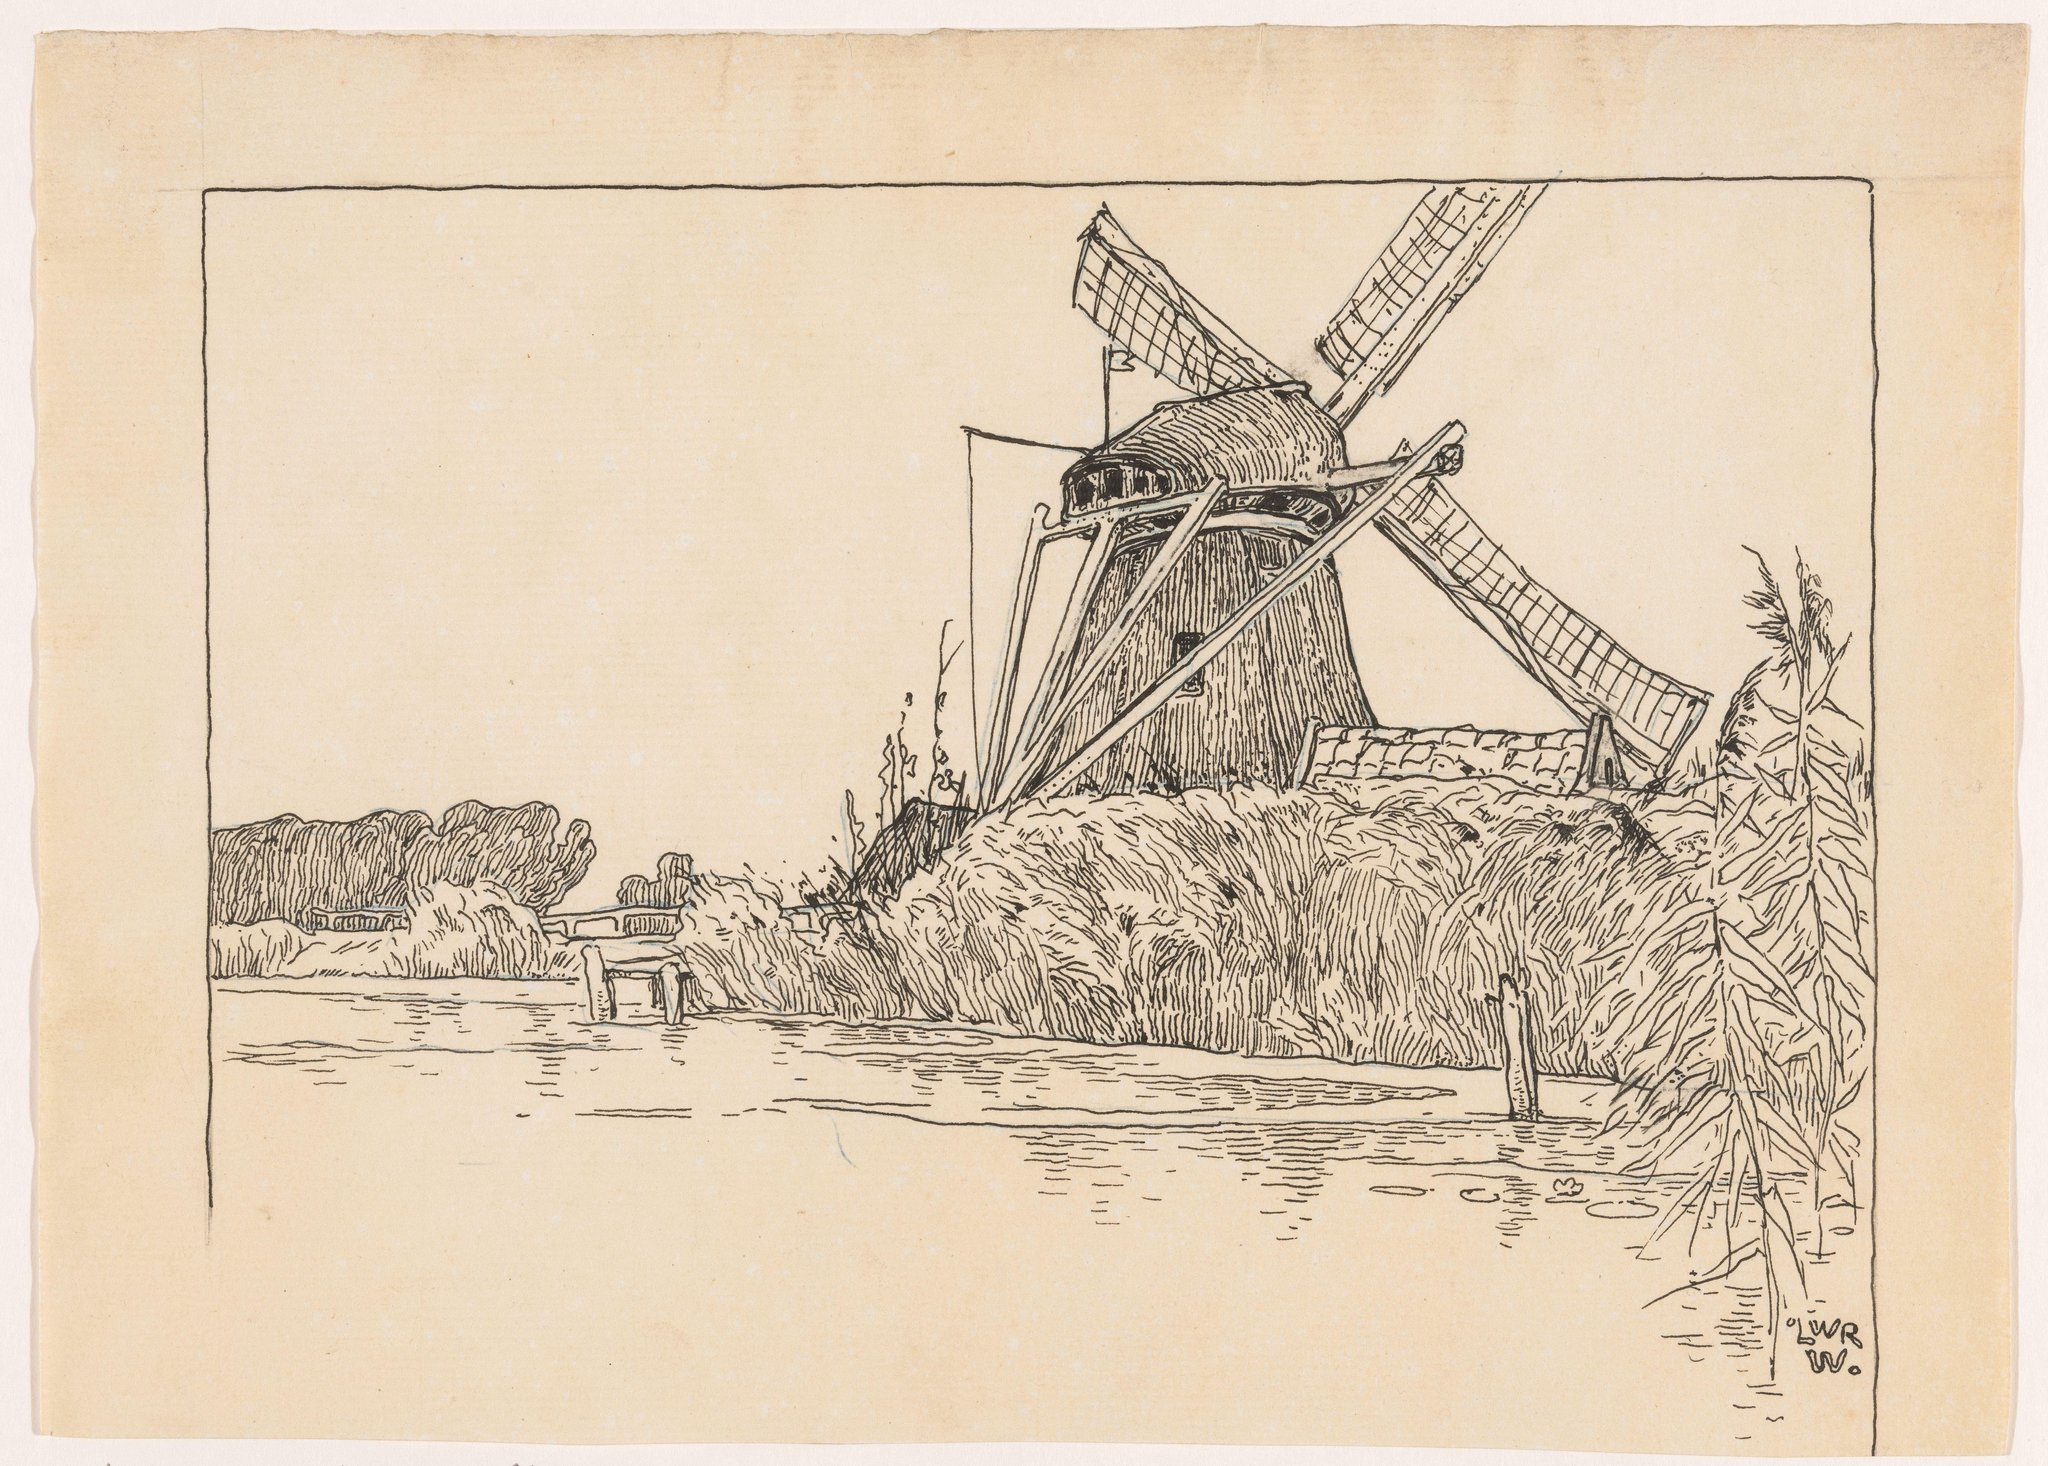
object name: drawing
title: Molen aan een waterkant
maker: willem wenckebach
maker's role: designer, draughtsman, painter, print maker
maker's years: 1860-1937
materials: ink, paper, pencil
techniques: pen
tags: watermill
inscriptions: collector's mark: Lugt 2228a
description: Ontwerp voor: Knappert, Emilie C. Kijkjes in de plantenwereld. Loman & Funke: Amsterdam, 1893.